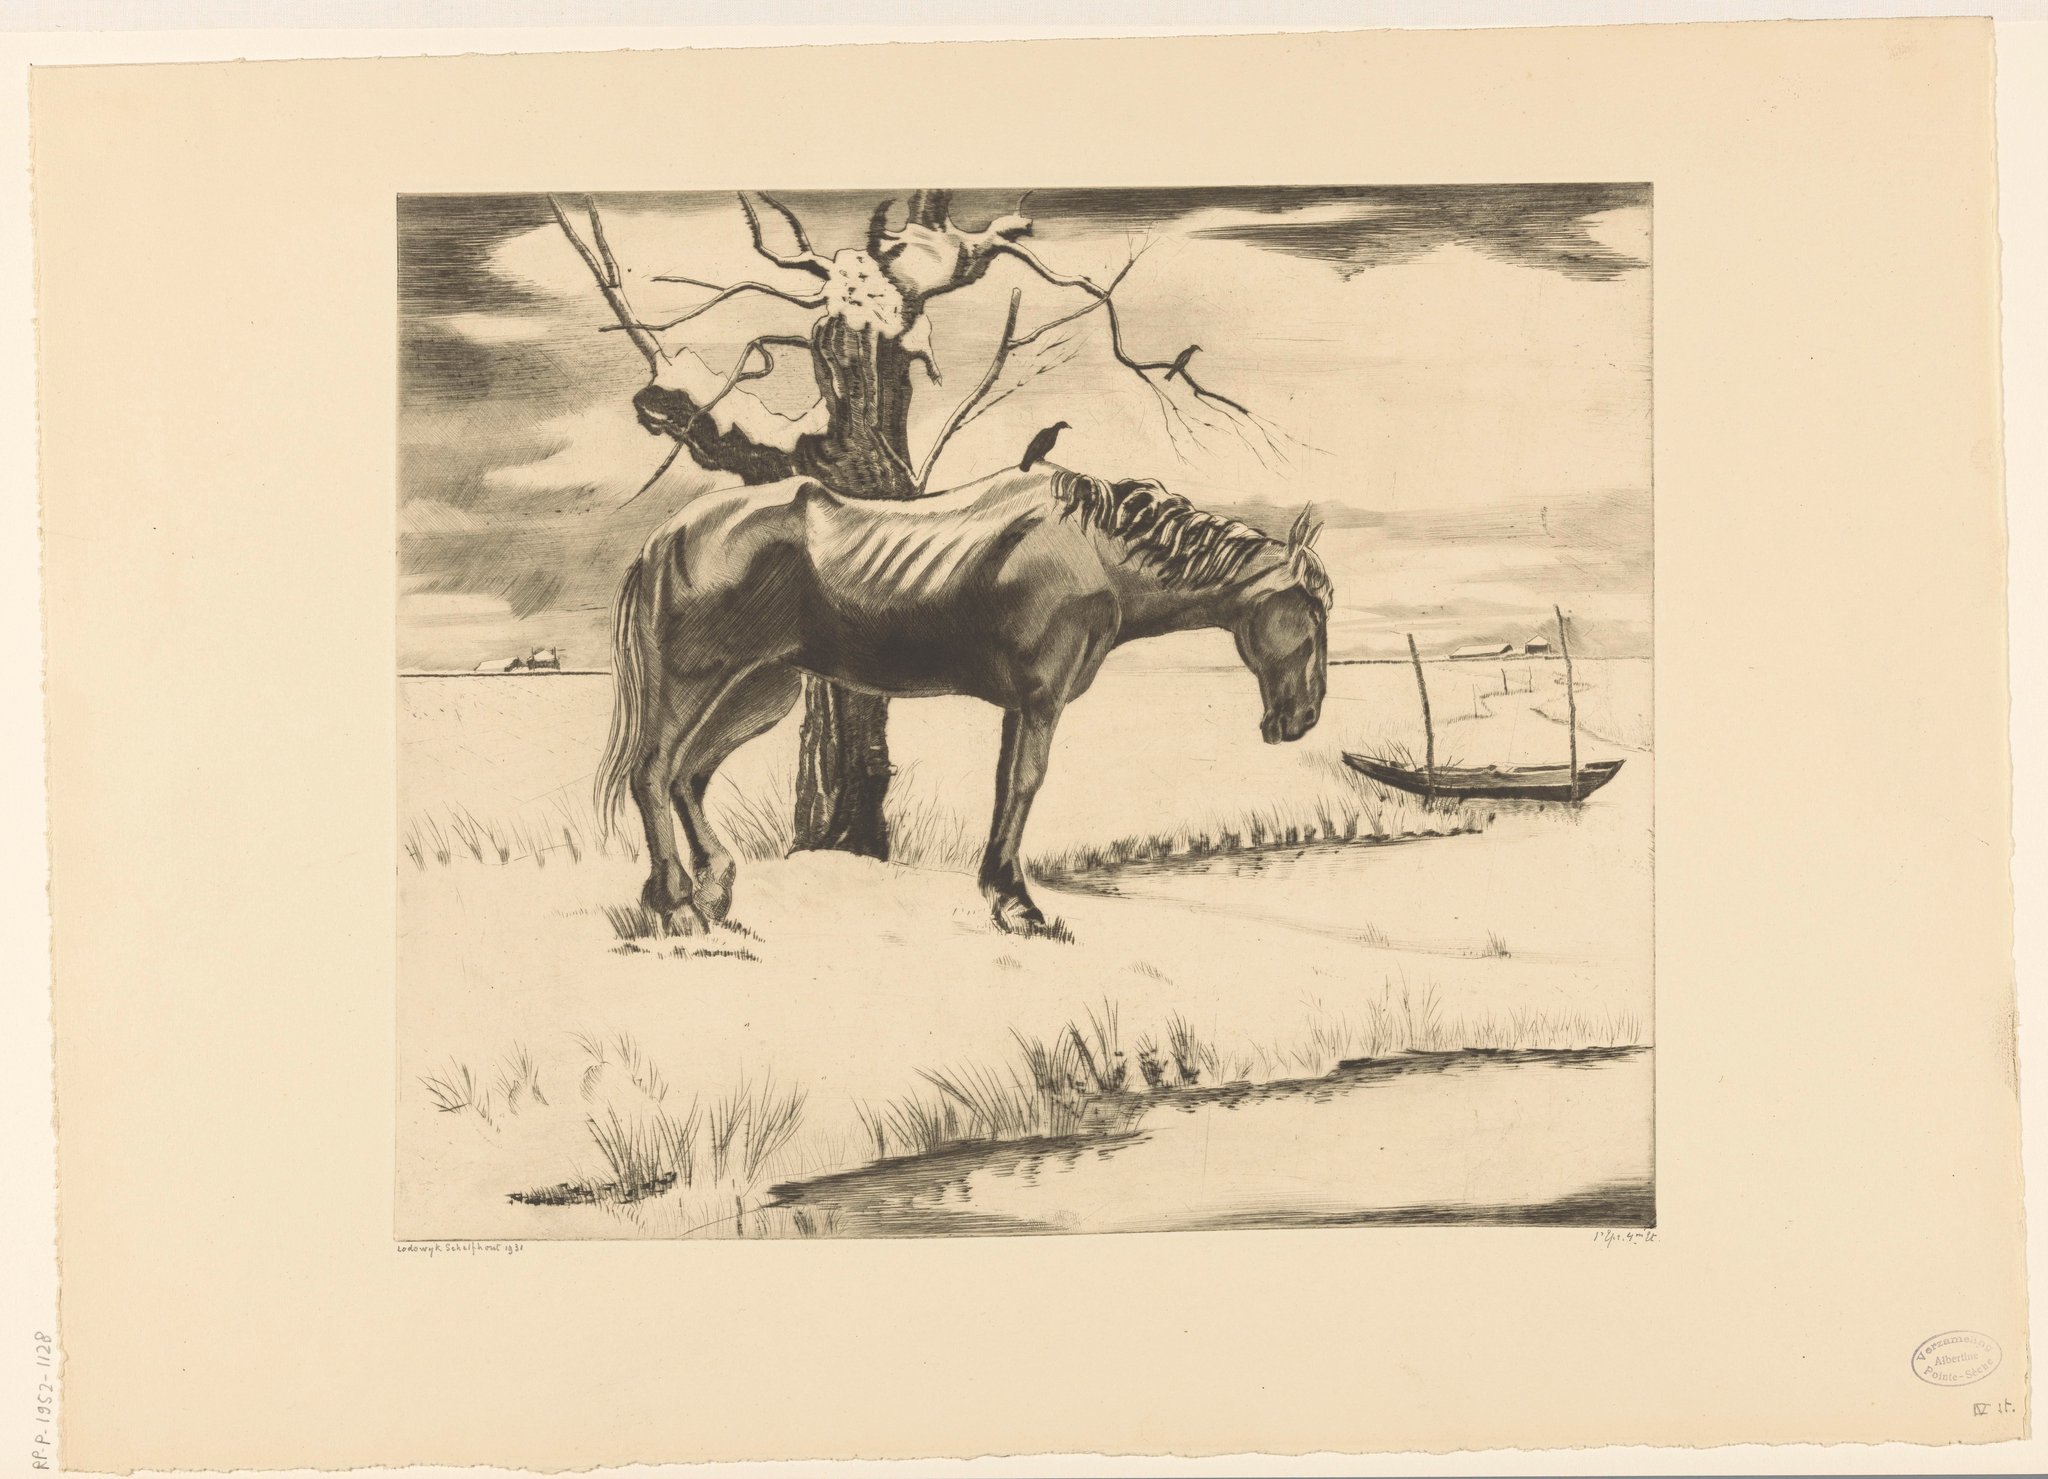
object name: print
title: Paard in een besneeuwd landschap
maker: lodewijk schelfhout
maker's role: draughtsman, print maker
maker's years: 1881-1943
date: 1931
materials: paper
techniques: drypoint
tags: trees (+ bare plant), water course, snow, horse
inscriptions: collector's mark: Lugt 5i, collector's mark: Lugt 2228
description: Op de rug van het paard zit een vogel. Achter het paard een boom met kale takken, waar ook een vogel op zit. Op de achtergrond boerderijen met hooischuren en een vaart met een afgemeerde schuit.